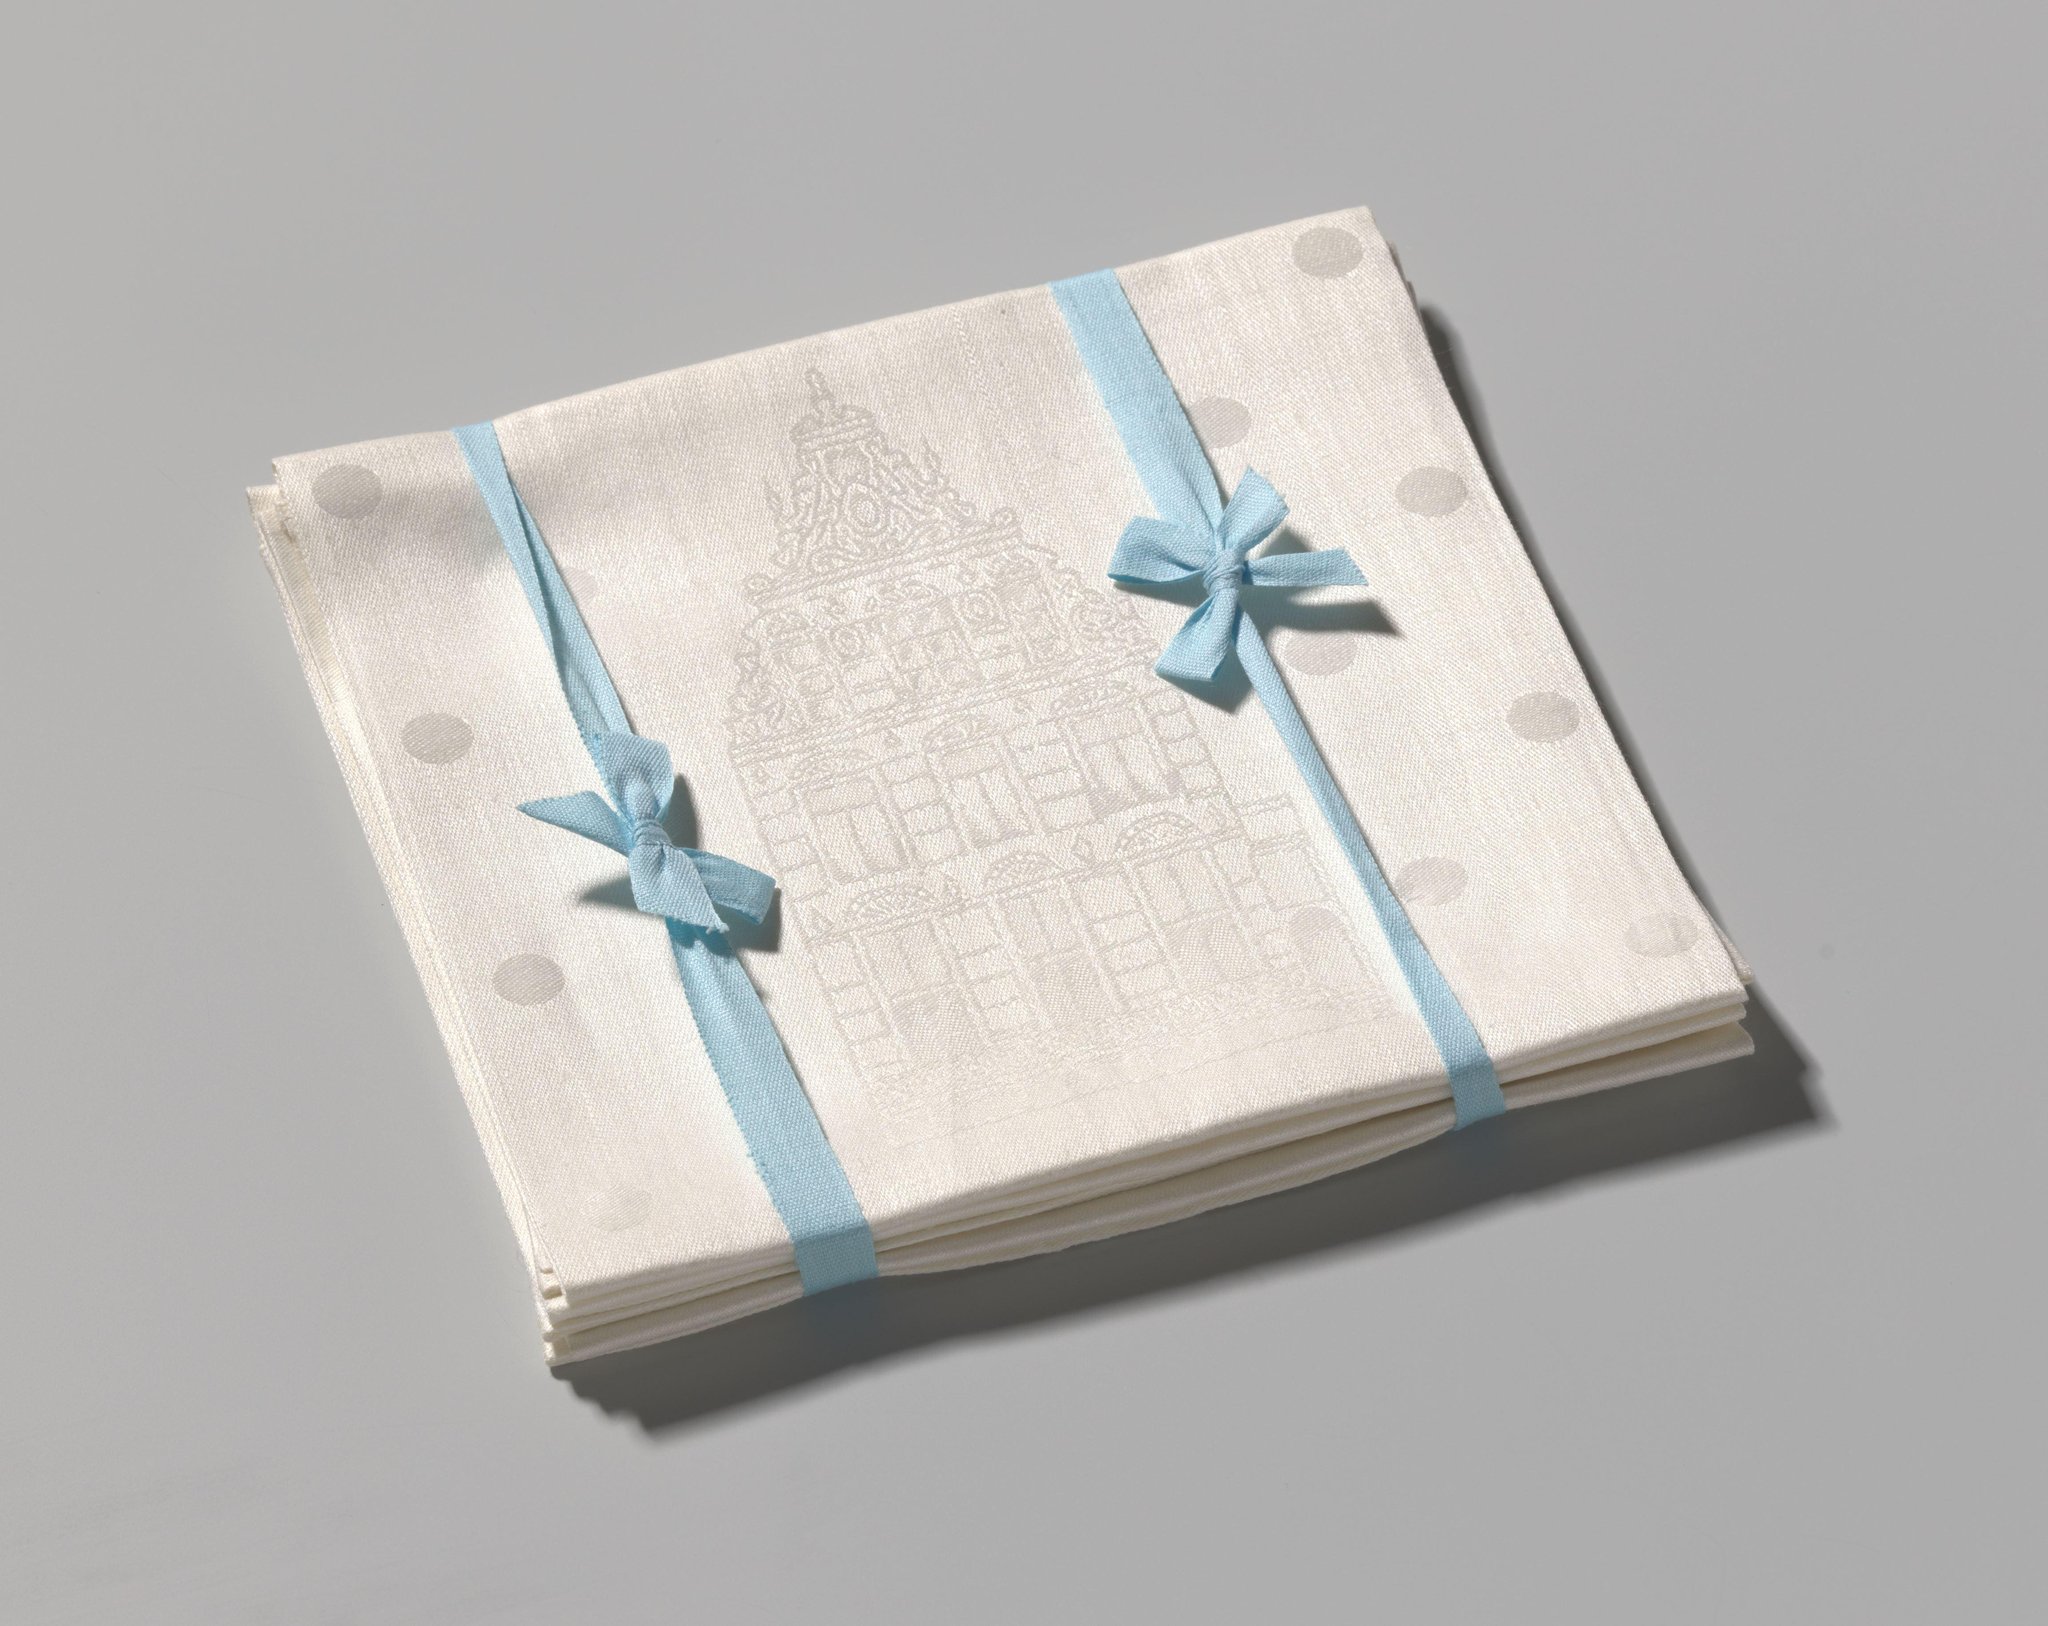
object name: napkin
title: Servet van linnendamast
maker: Anonymous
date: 1965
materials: linen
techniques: damask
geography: eindhoven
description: Linnen damasten servet ter herdenking van De Groote Societeit Groningen, 1765-1965".